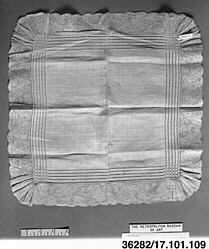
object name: handkerchief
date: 1601-1800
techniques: lace